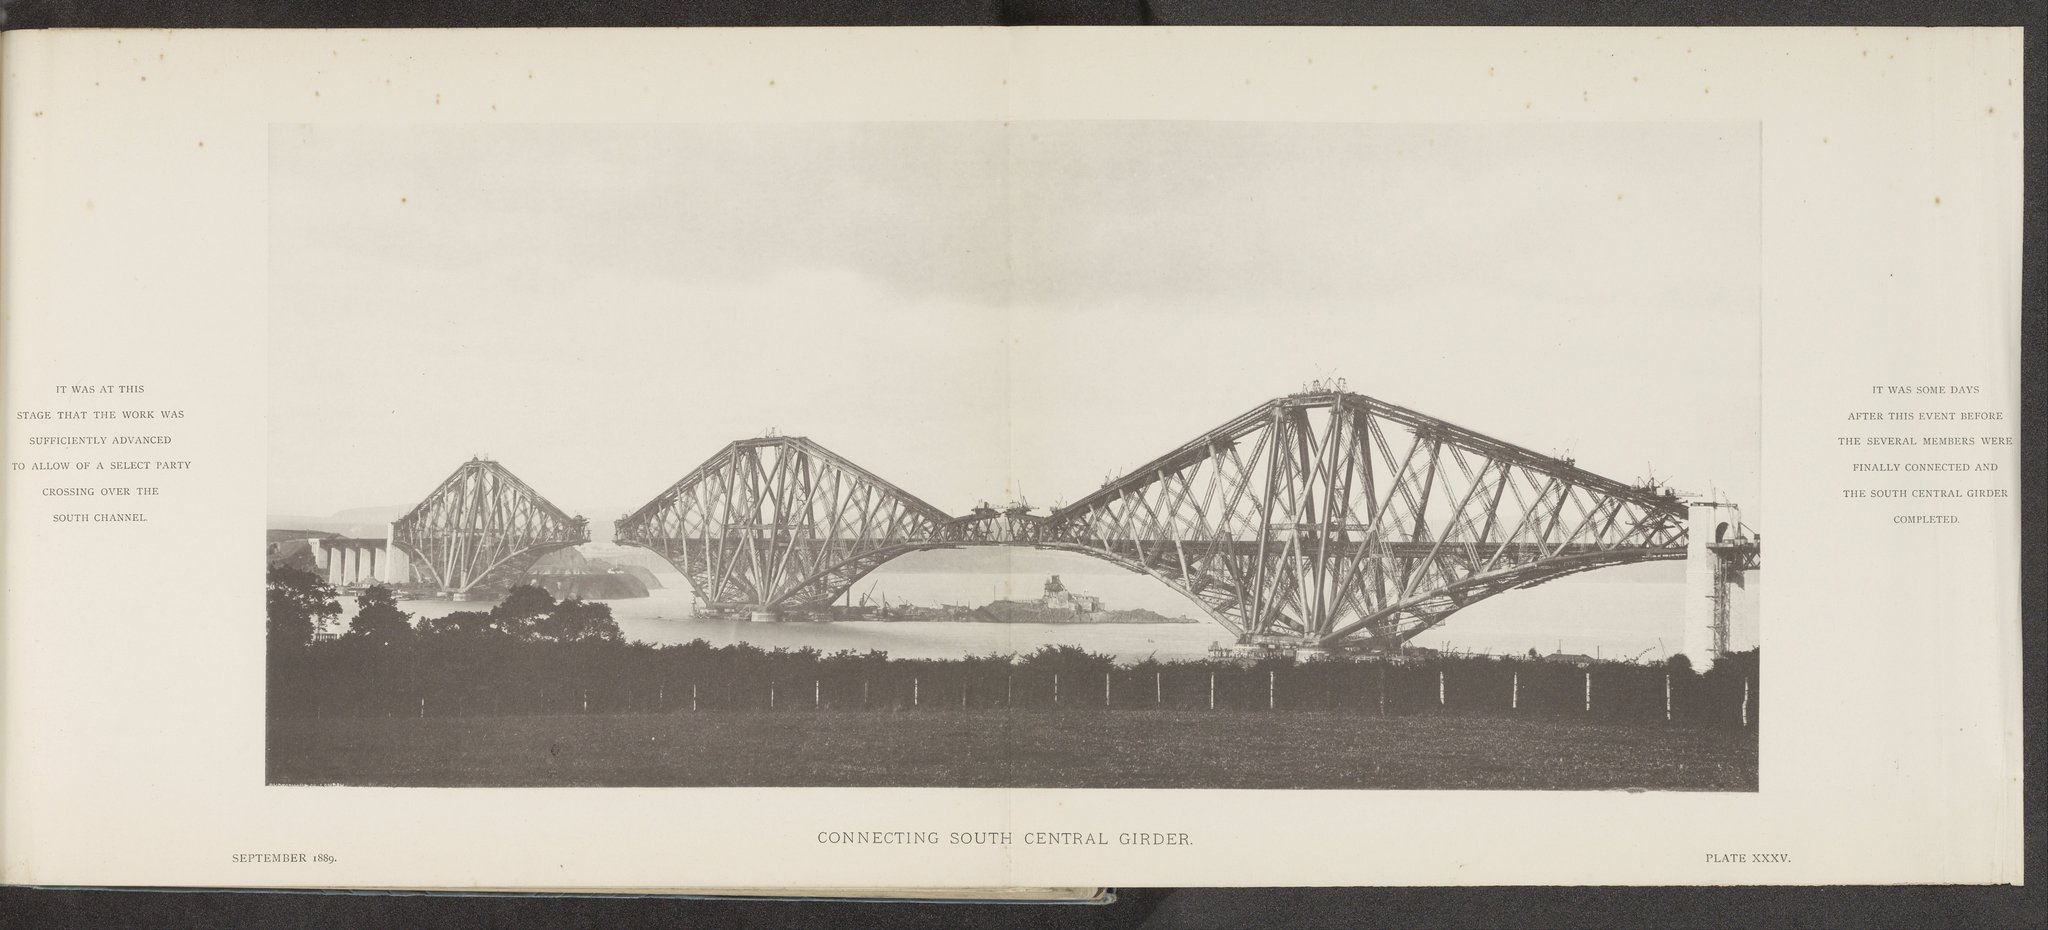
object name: page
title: Connecting south central girder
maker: Anonymous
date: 1809-1889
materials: paper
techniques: photograph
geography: united kingdom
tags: building materials, bridge, building-site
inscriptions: number: ‘Plate XXXV.’, inscription: ‘It was at this stage (...) the south central girder completed.’